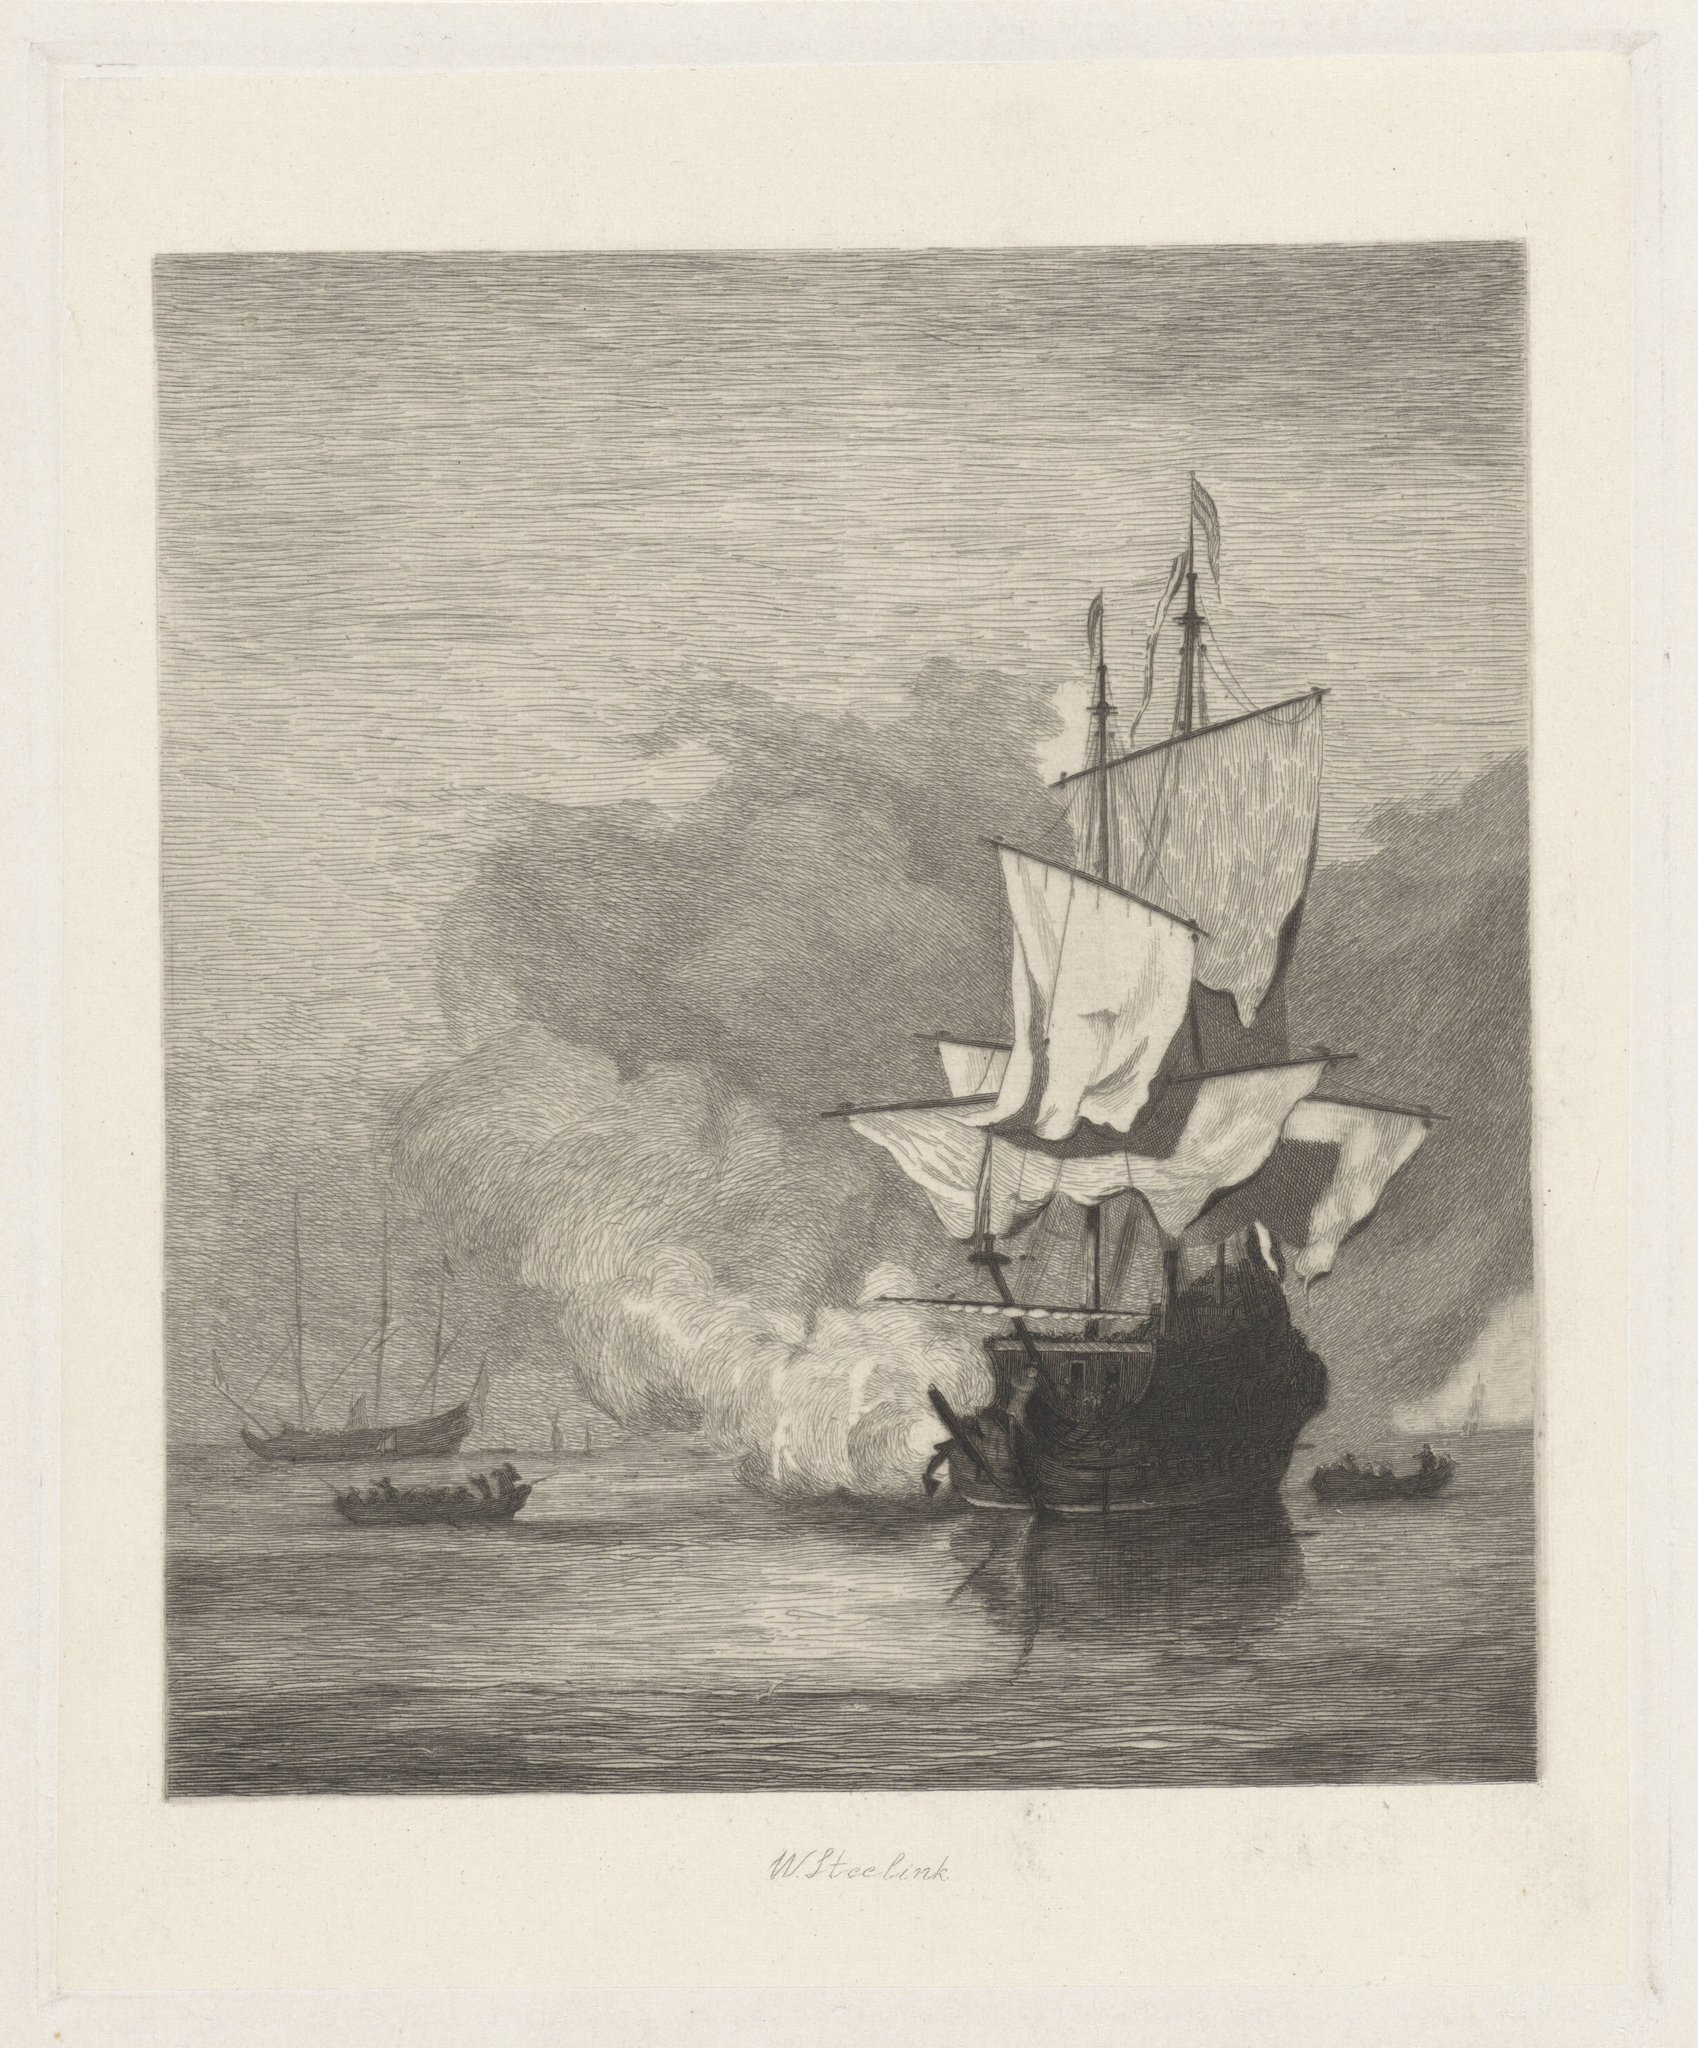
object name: print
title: Het kanonschot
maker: willem steelink (i)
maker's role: draughtsman, print maker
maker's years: 1826-1913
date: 1866-1890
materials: paper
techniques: etching, intaglio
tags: sailing-ship, sailing-boat, cannon shots (military salute)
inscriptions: collector's mark: Lugt 2228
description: Het kanonschot. Een oorlogsschip bij windstilte met slappe zeilen lost een kanonschot. Aan weerszijden twee sloepen, in de verte een ander oorlogsschip, met gestreken zeilen.